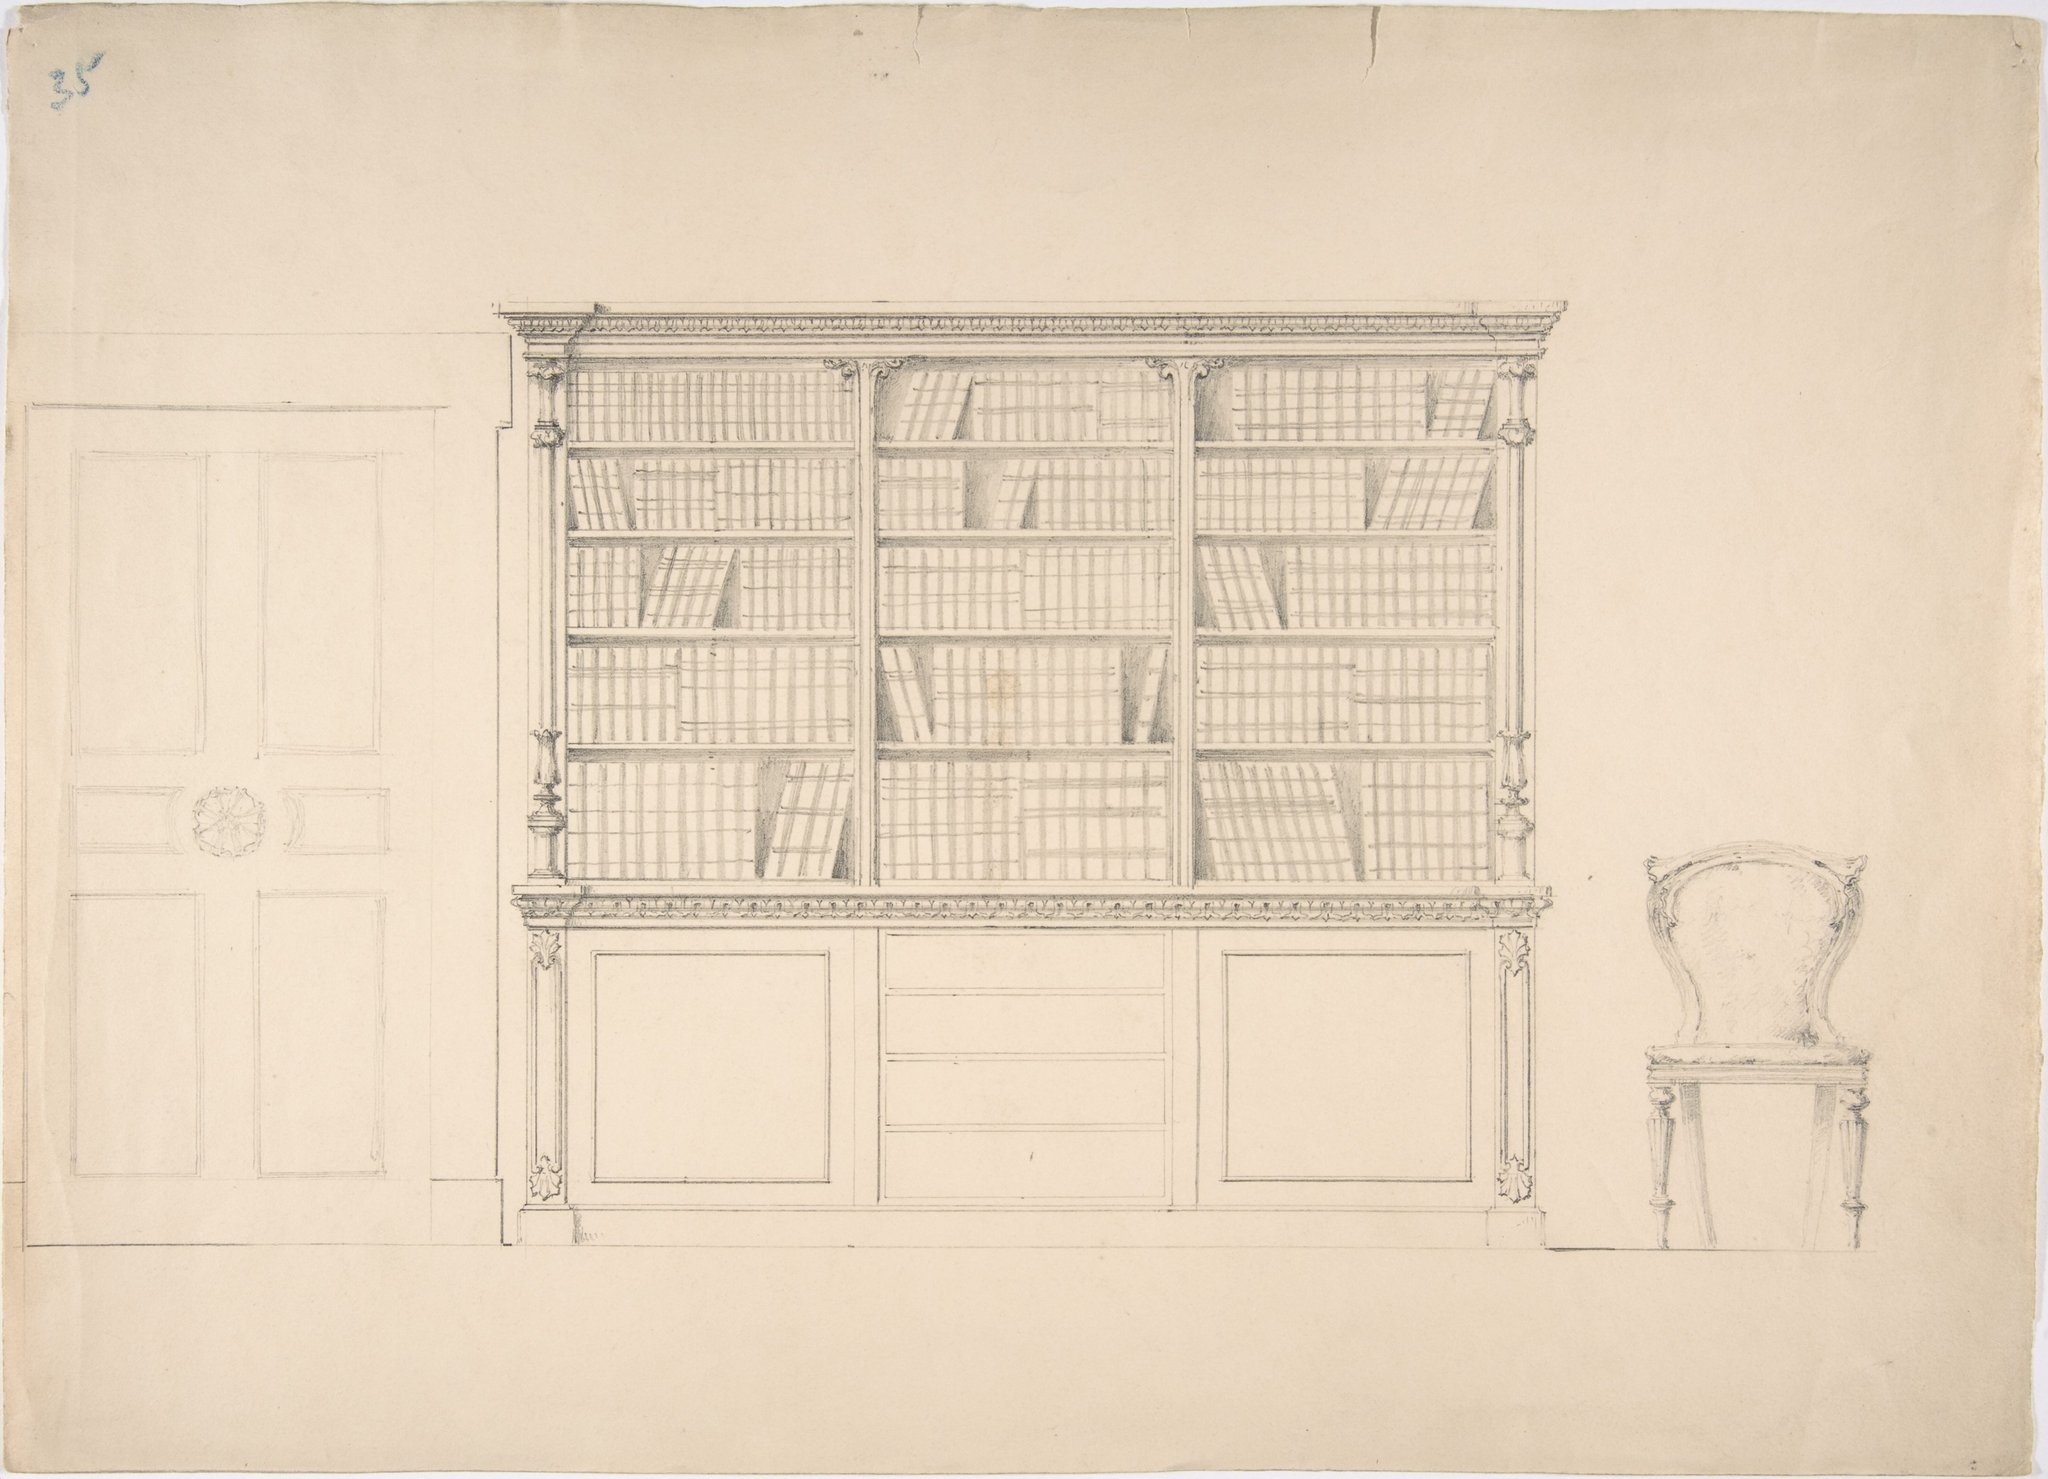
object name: drawing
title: Design for a Large Bookcabinet, with a Door at Left and a Chair at Right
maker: anonymous, british, 19th century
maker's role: artist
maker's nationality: british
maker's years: 1800-1900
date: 1801-1833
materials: graphite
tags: books,doors,chairs,cabinets